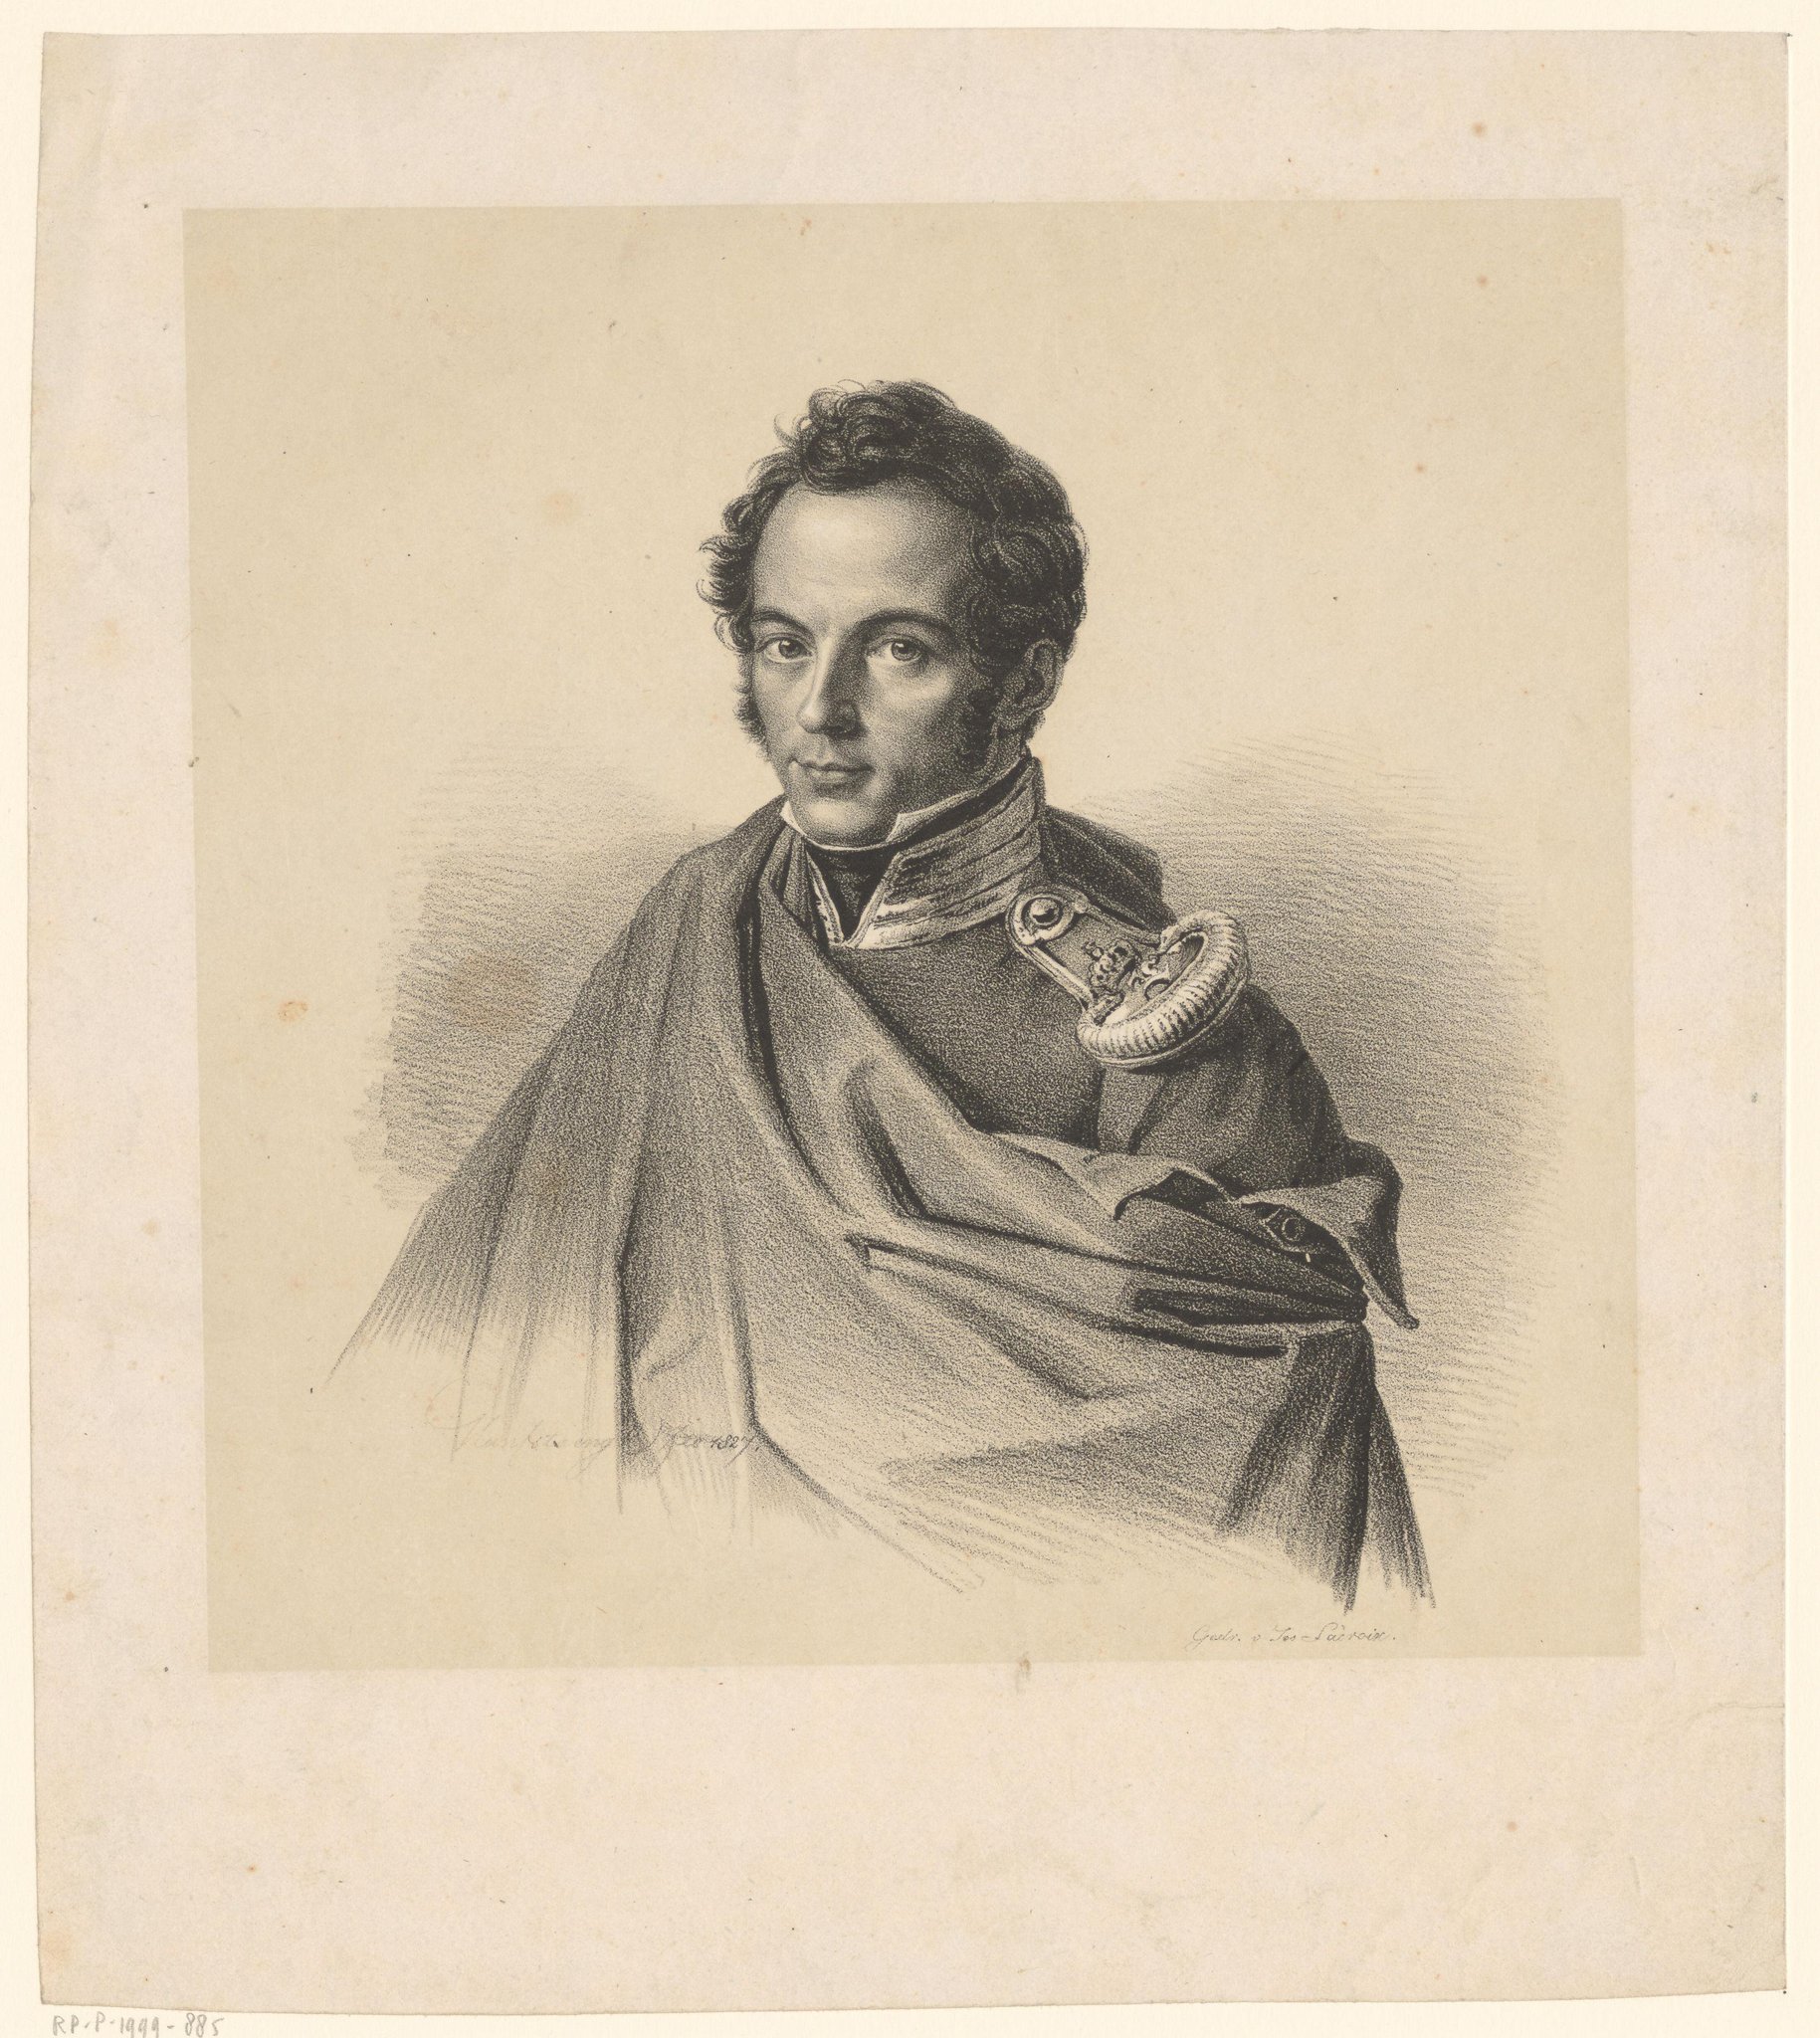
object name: print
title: Portret van een onbekende man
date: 1827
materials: paper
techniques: tone lithography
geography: germany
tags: adult man, historical persons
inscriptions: collector's mark: Lugt 2760, collector's mark: Lugt 2228, collector's mark: Lugt 4100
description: Ten halve lijve, naar links, in uniform, waaroverheen een losse schoudermantel.